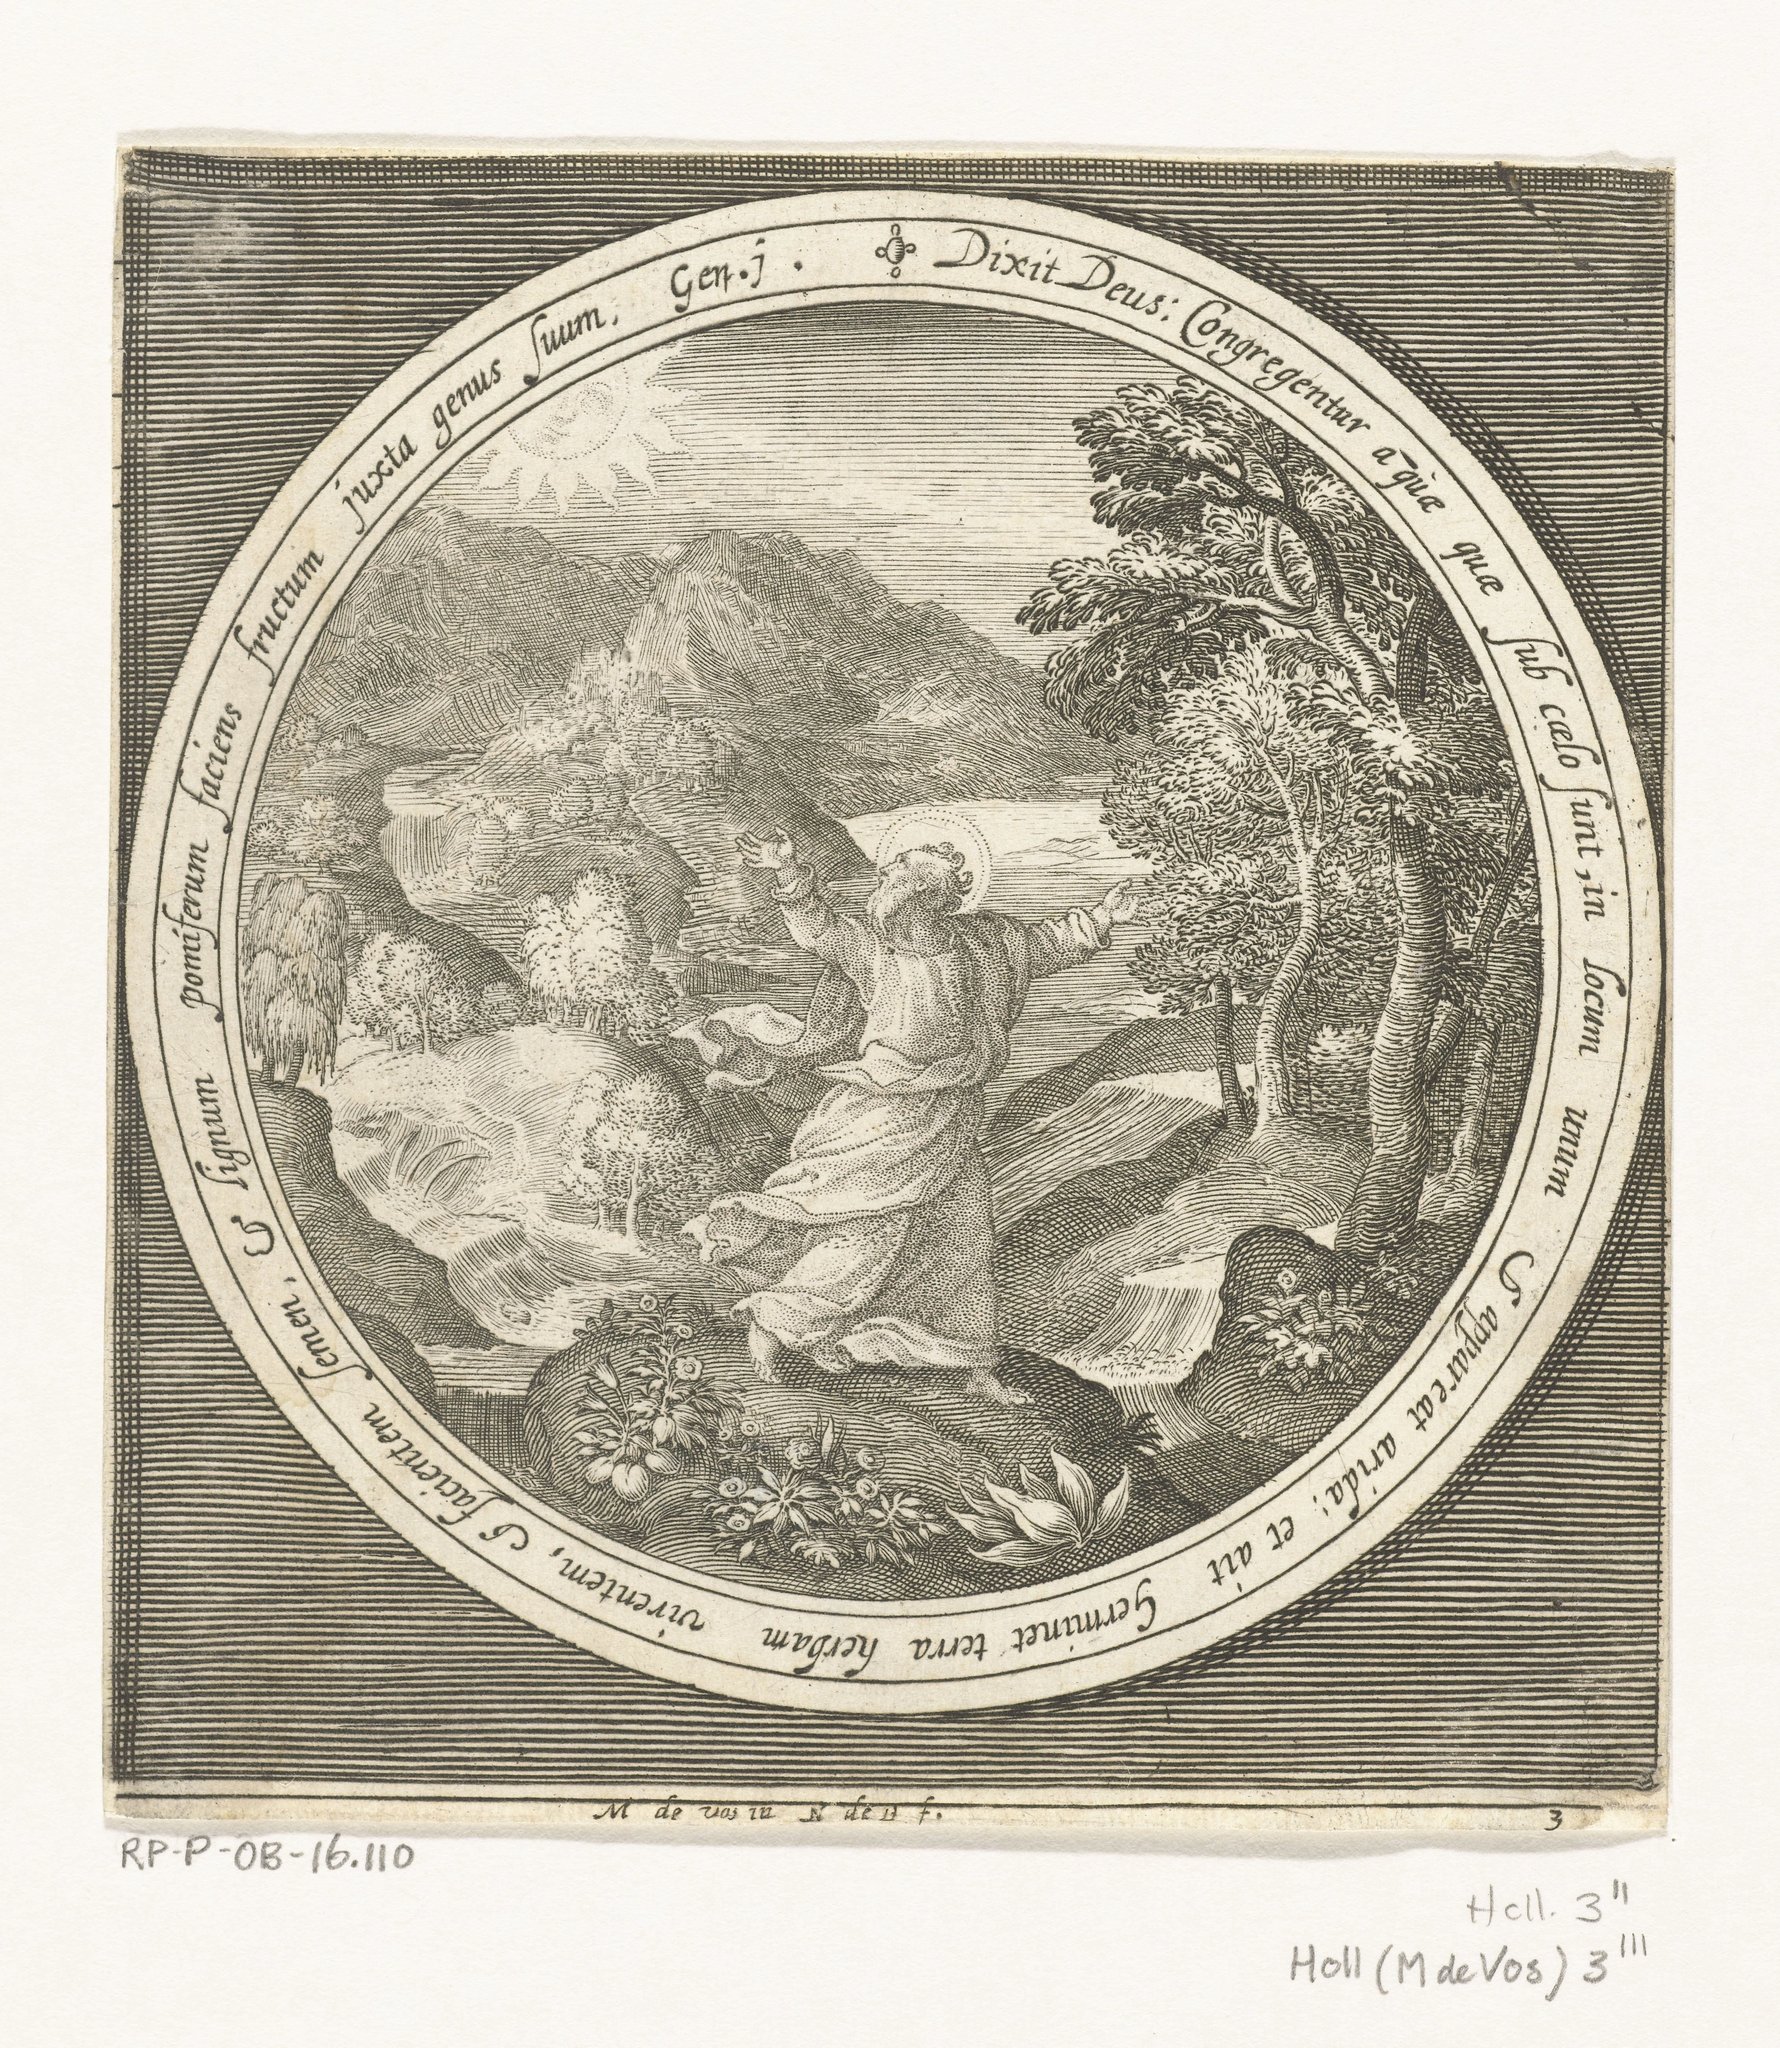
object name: print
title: Derde dag van schepping: God schept land en zaadvormende planten en bomen met vruchten die zaden dragen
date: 1581-1656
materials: paper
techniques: engraving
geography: netherlands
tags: gathering of the waters below the firmament; dry land appears and produces all kinds of plants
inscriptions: collector's mark: Lugt 2228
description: Derde dag van schepping: God schept land en zaadvormende planten en bomen met vruchten die zaden dragen. Het water trekt zich terug in rivieren en de zee. In medaillon met als opschrift een bijbeltekst in Latijn uit Genesis 1, binnen rechthoekige omlijsting.